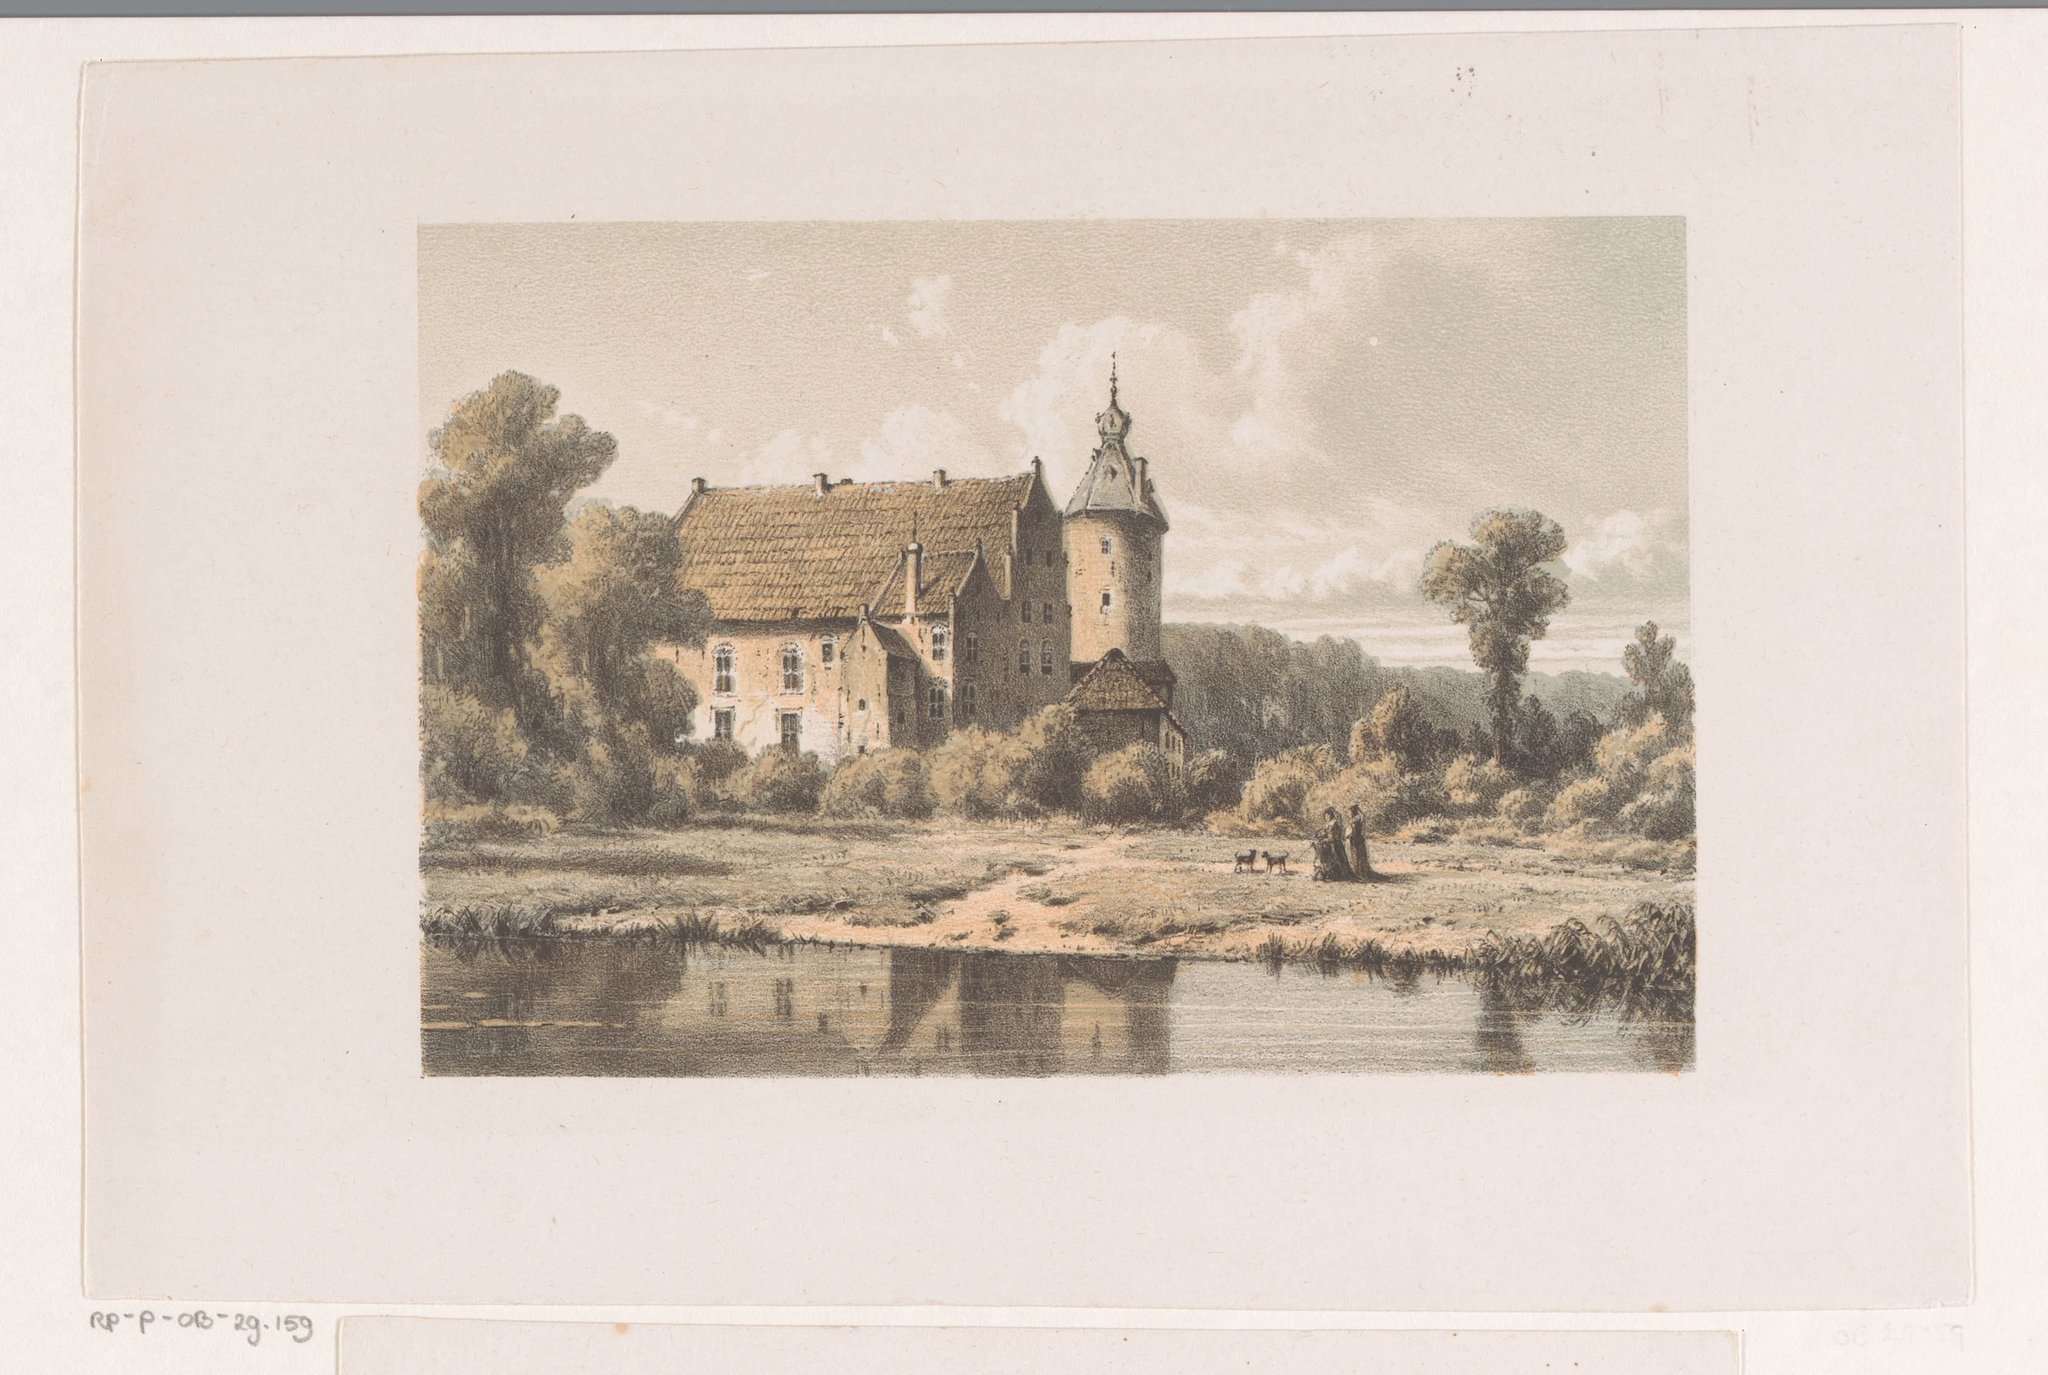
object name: print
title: Kasteel Rechteren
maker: jacob jan van der maaten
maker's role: draughtsman, print maker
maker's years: 1820-1879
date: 1854-1861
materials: paper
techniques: tone lithography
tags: castle, strolling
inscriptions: collector's mark: Lugt 2228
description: Uitgegeven in: Lennep, J. van, Merkwaardige Kasteelen in Nederland. Amsterdam, G. W. Tielkemeijer: 1854-1861.